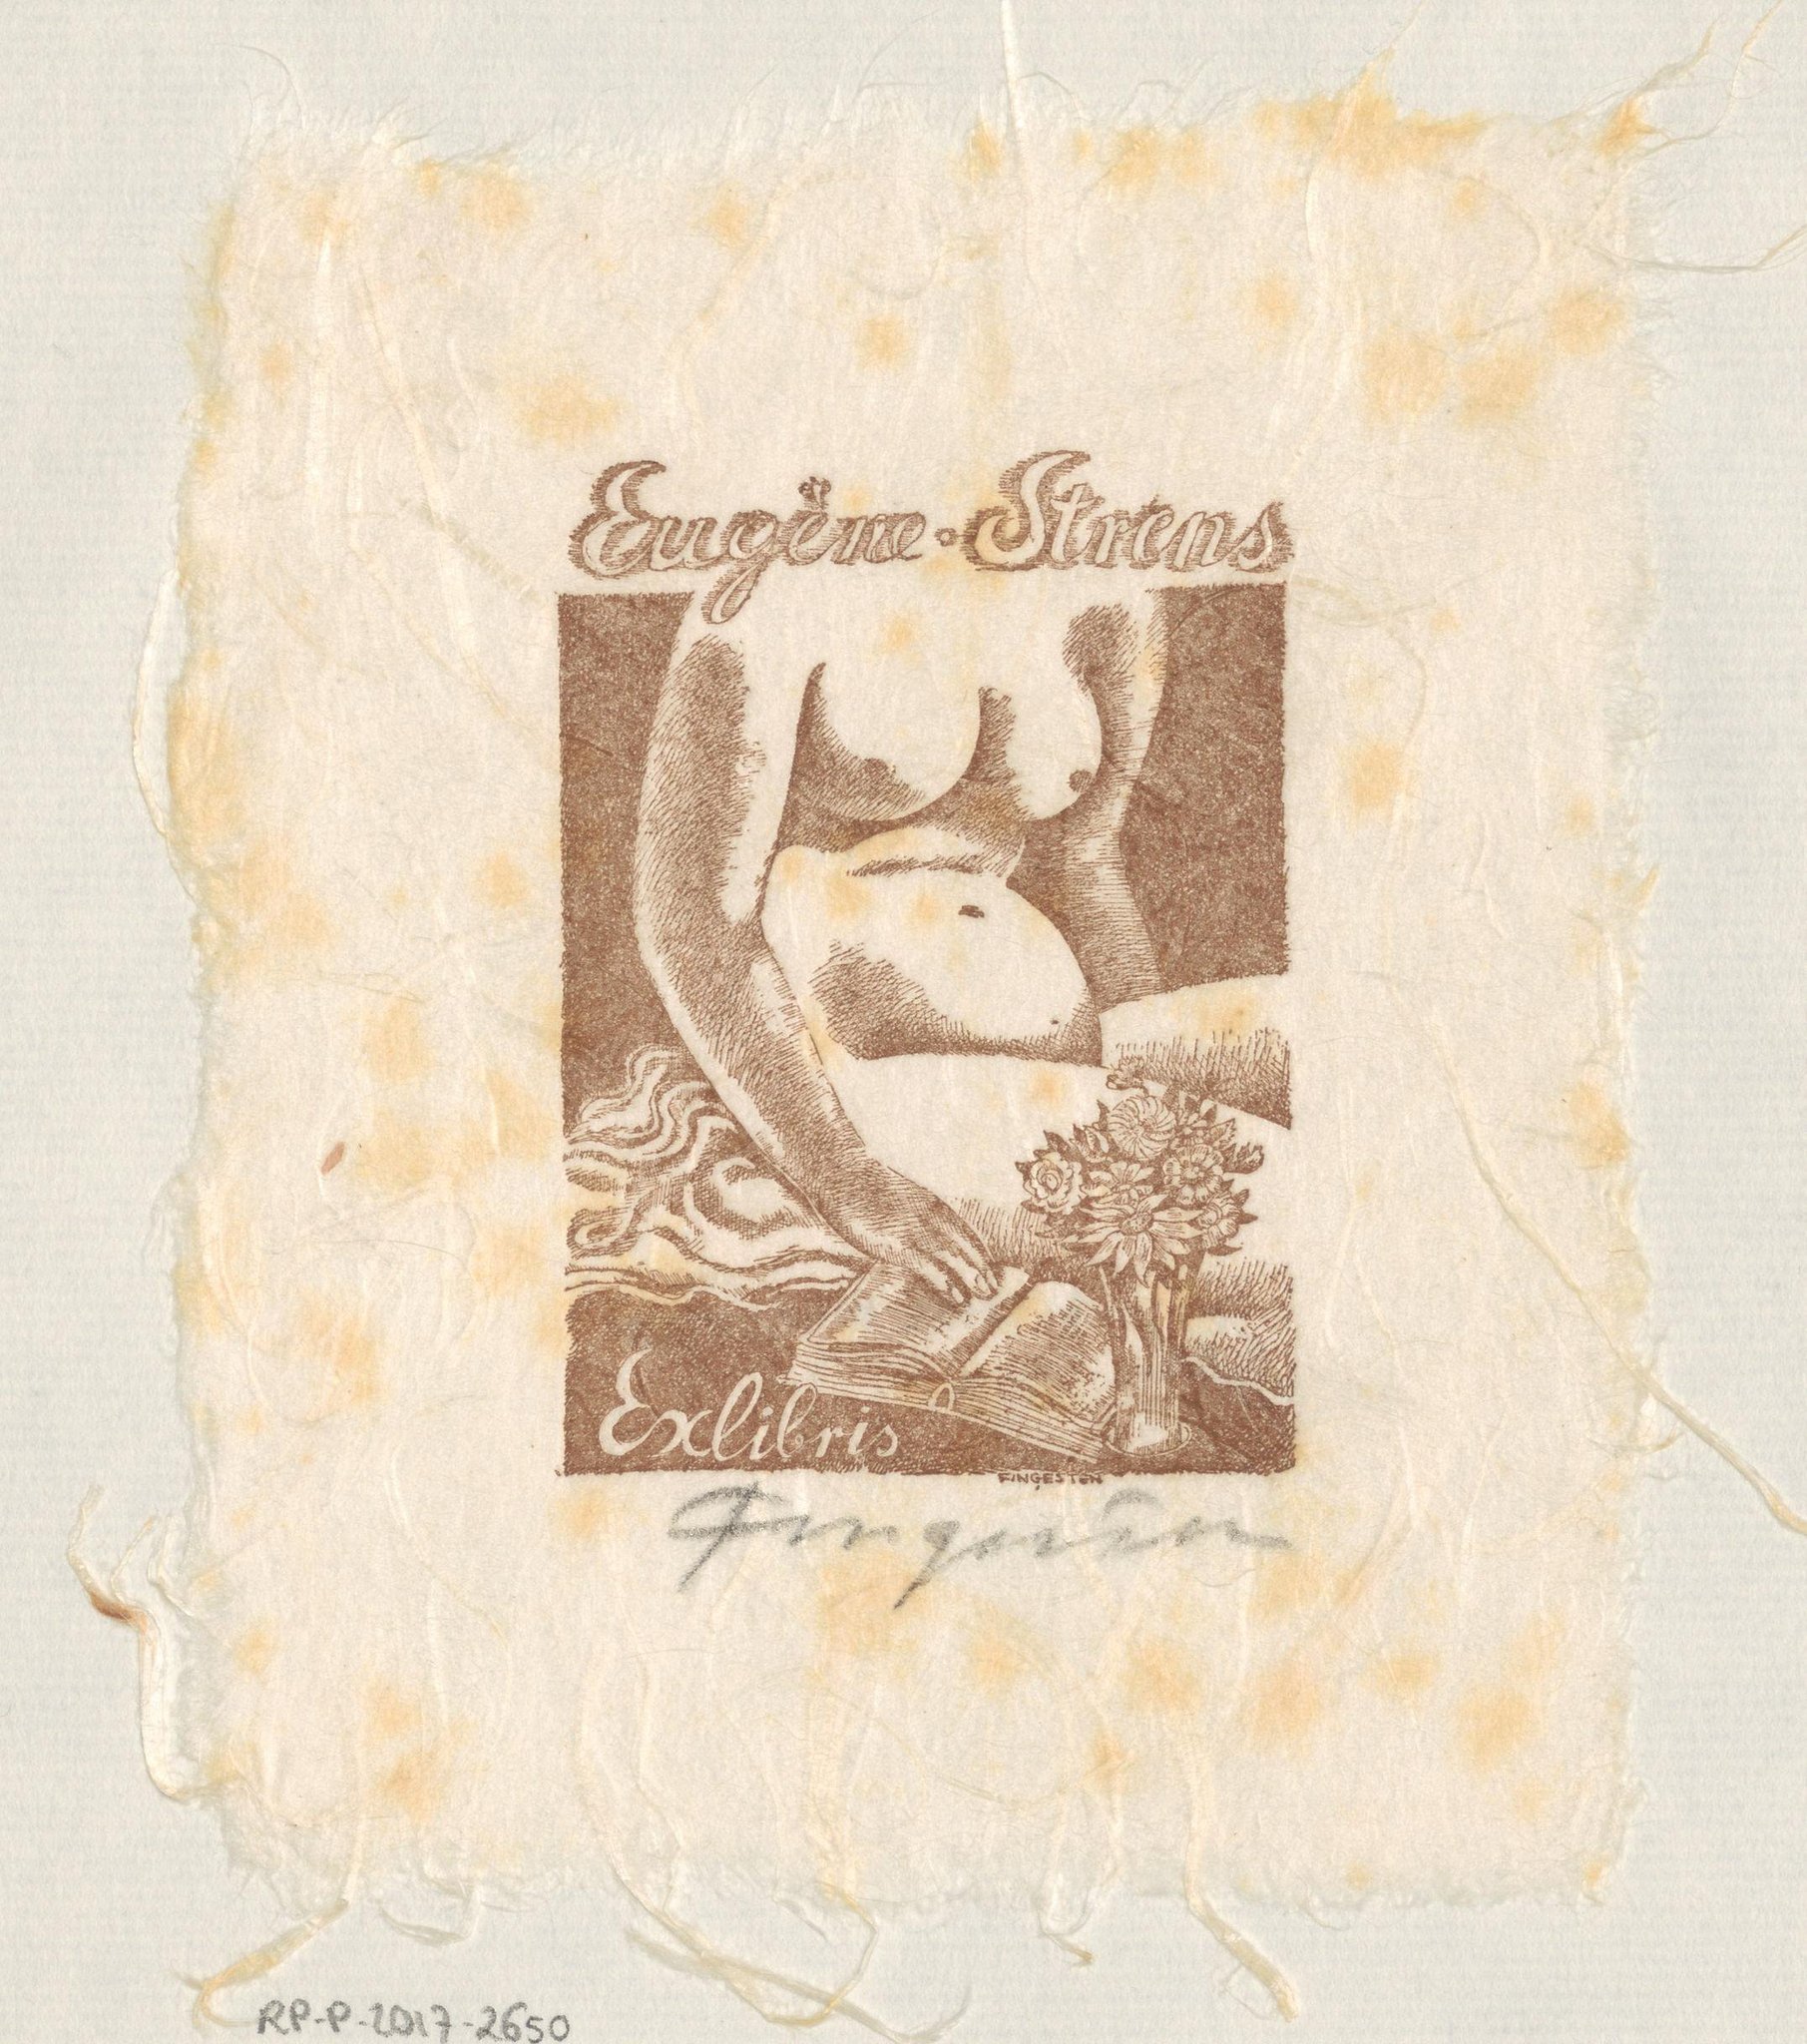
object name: bookplate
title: Ex libris van Eugène Strens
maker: michel fingesten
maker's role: painter, print maker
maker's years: 1884-1943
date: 1894-1943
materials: paper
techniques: etching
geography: italy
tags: engineer, eugène louis charles marie strens, woman (showing herself) undressed, quasi-nude, book, flowers in a vase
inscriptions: signature: ‘Fingesten’, workshop stamp: ‘Michel Fingesten’